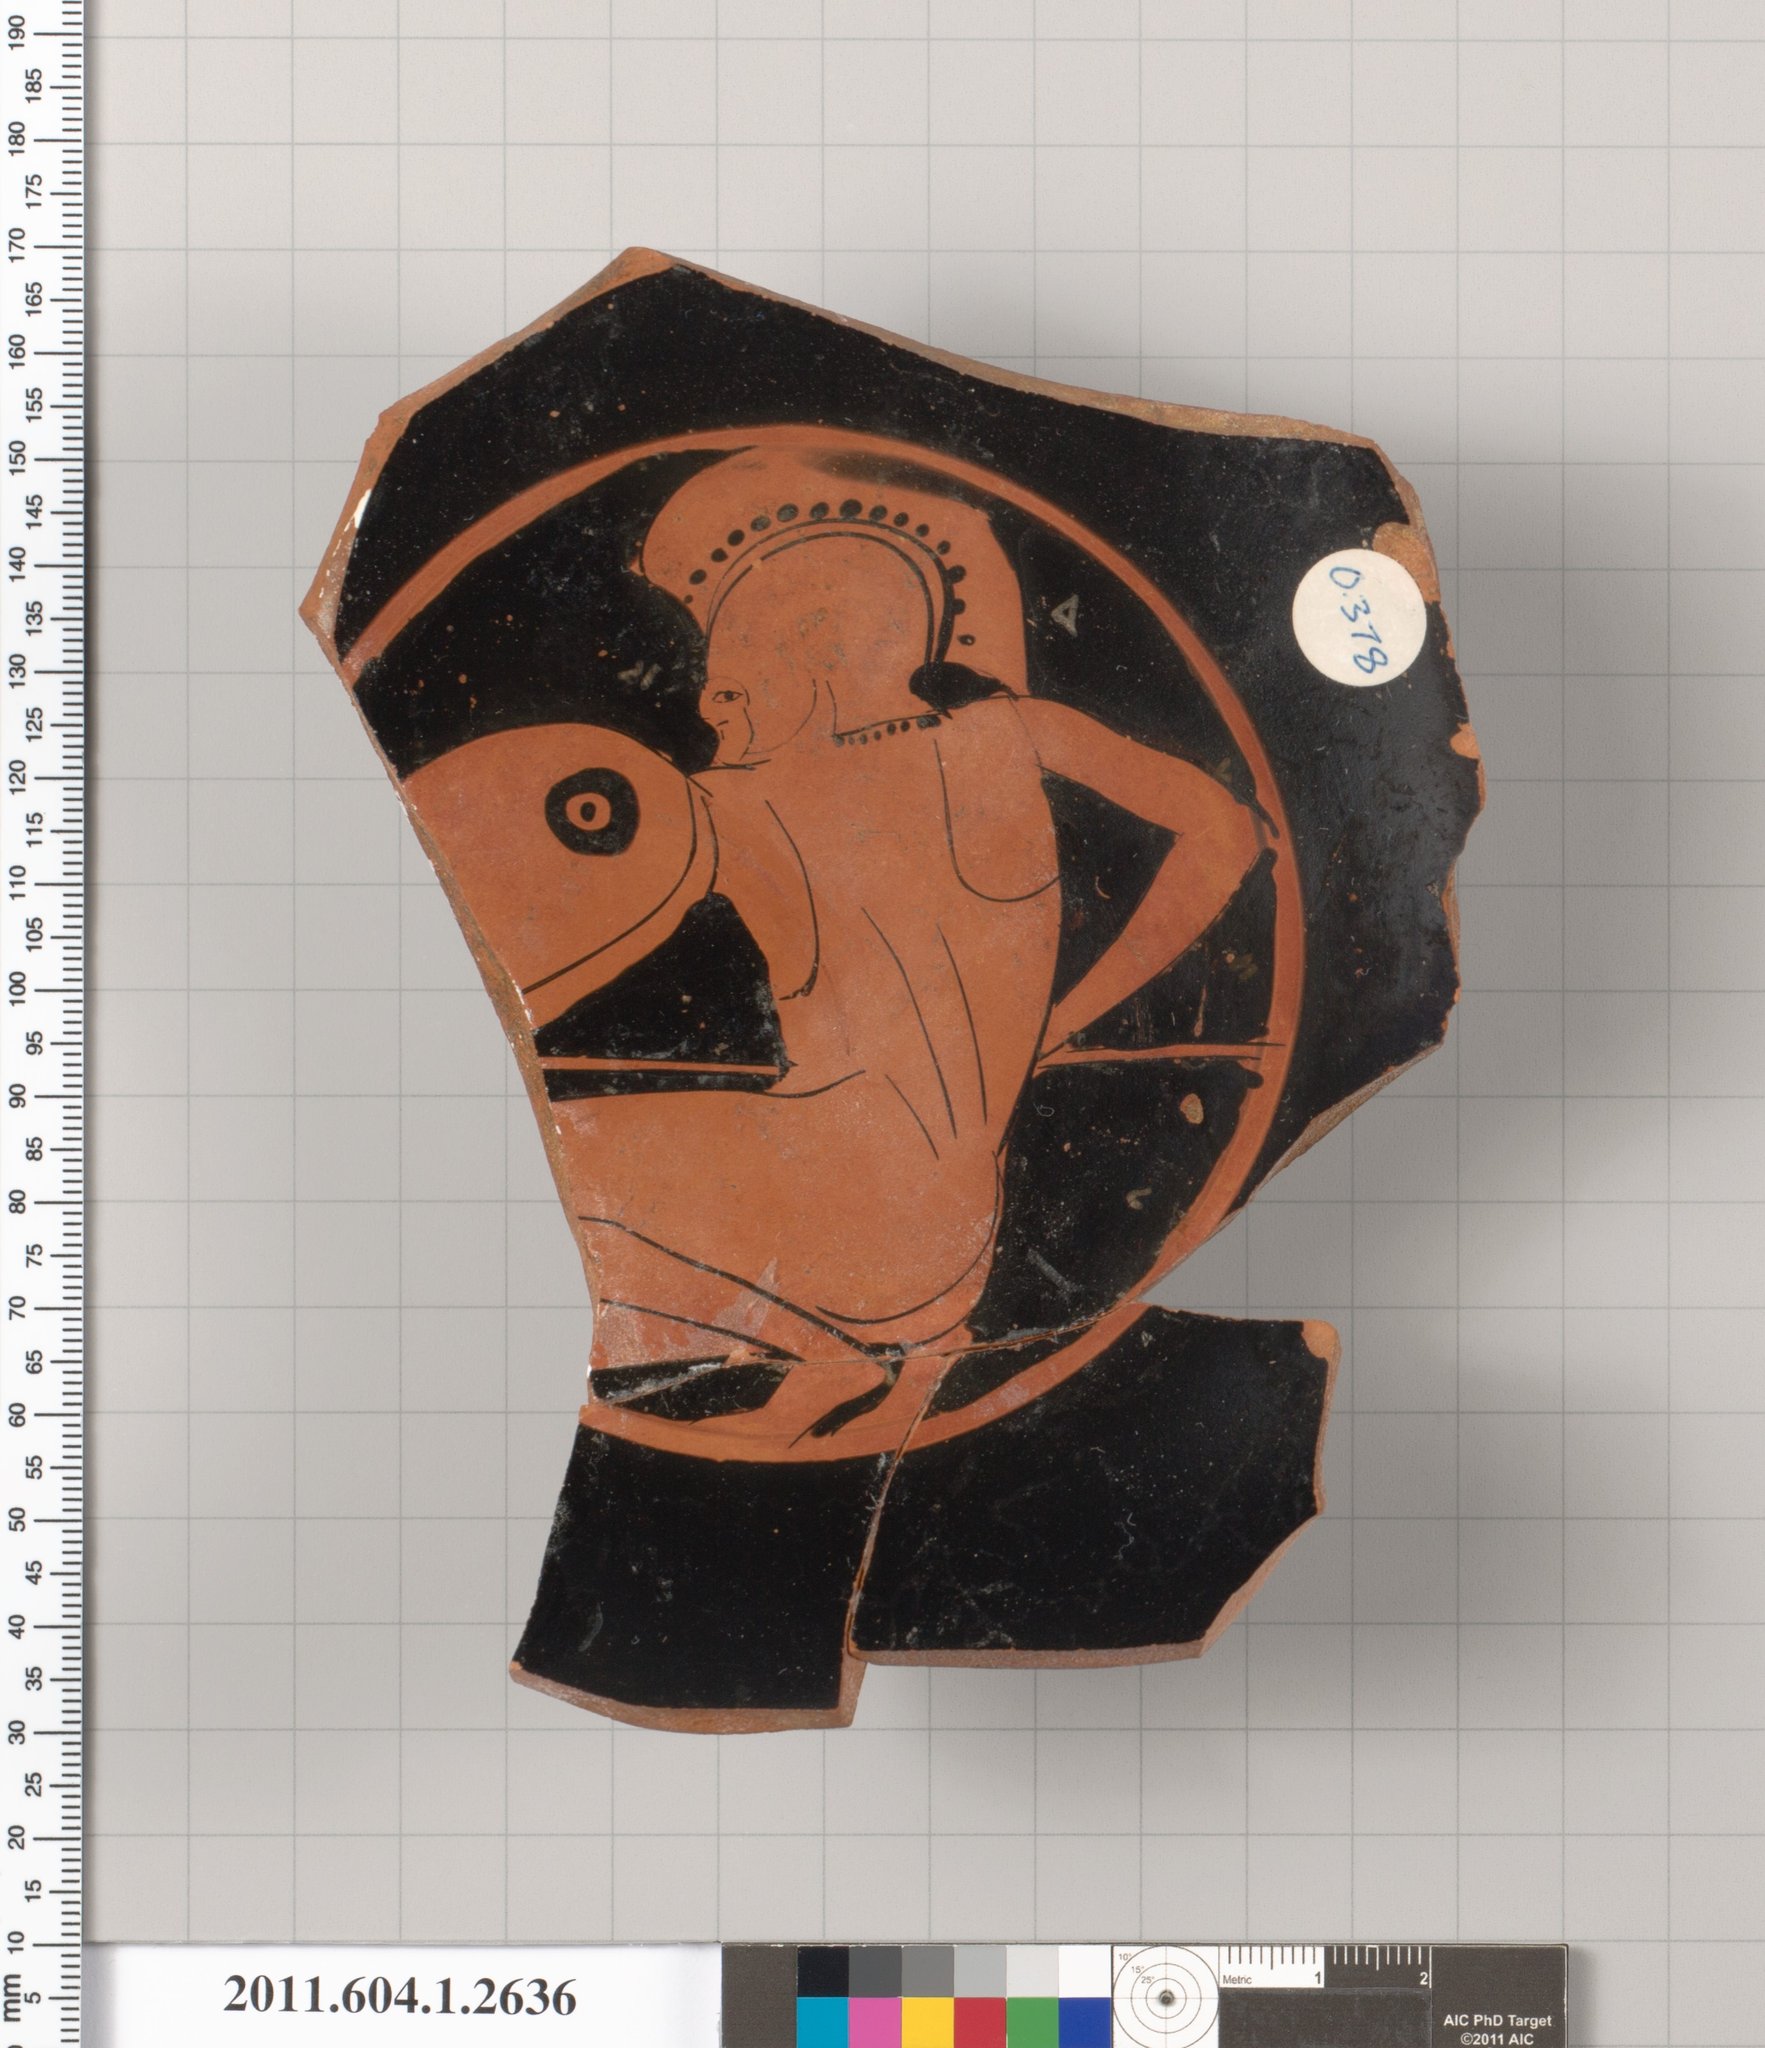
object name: kylix fragment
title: Terracotta fragment of a kylix (drinking cup)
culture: greek, attic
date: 520-500 BCE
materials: terracotta